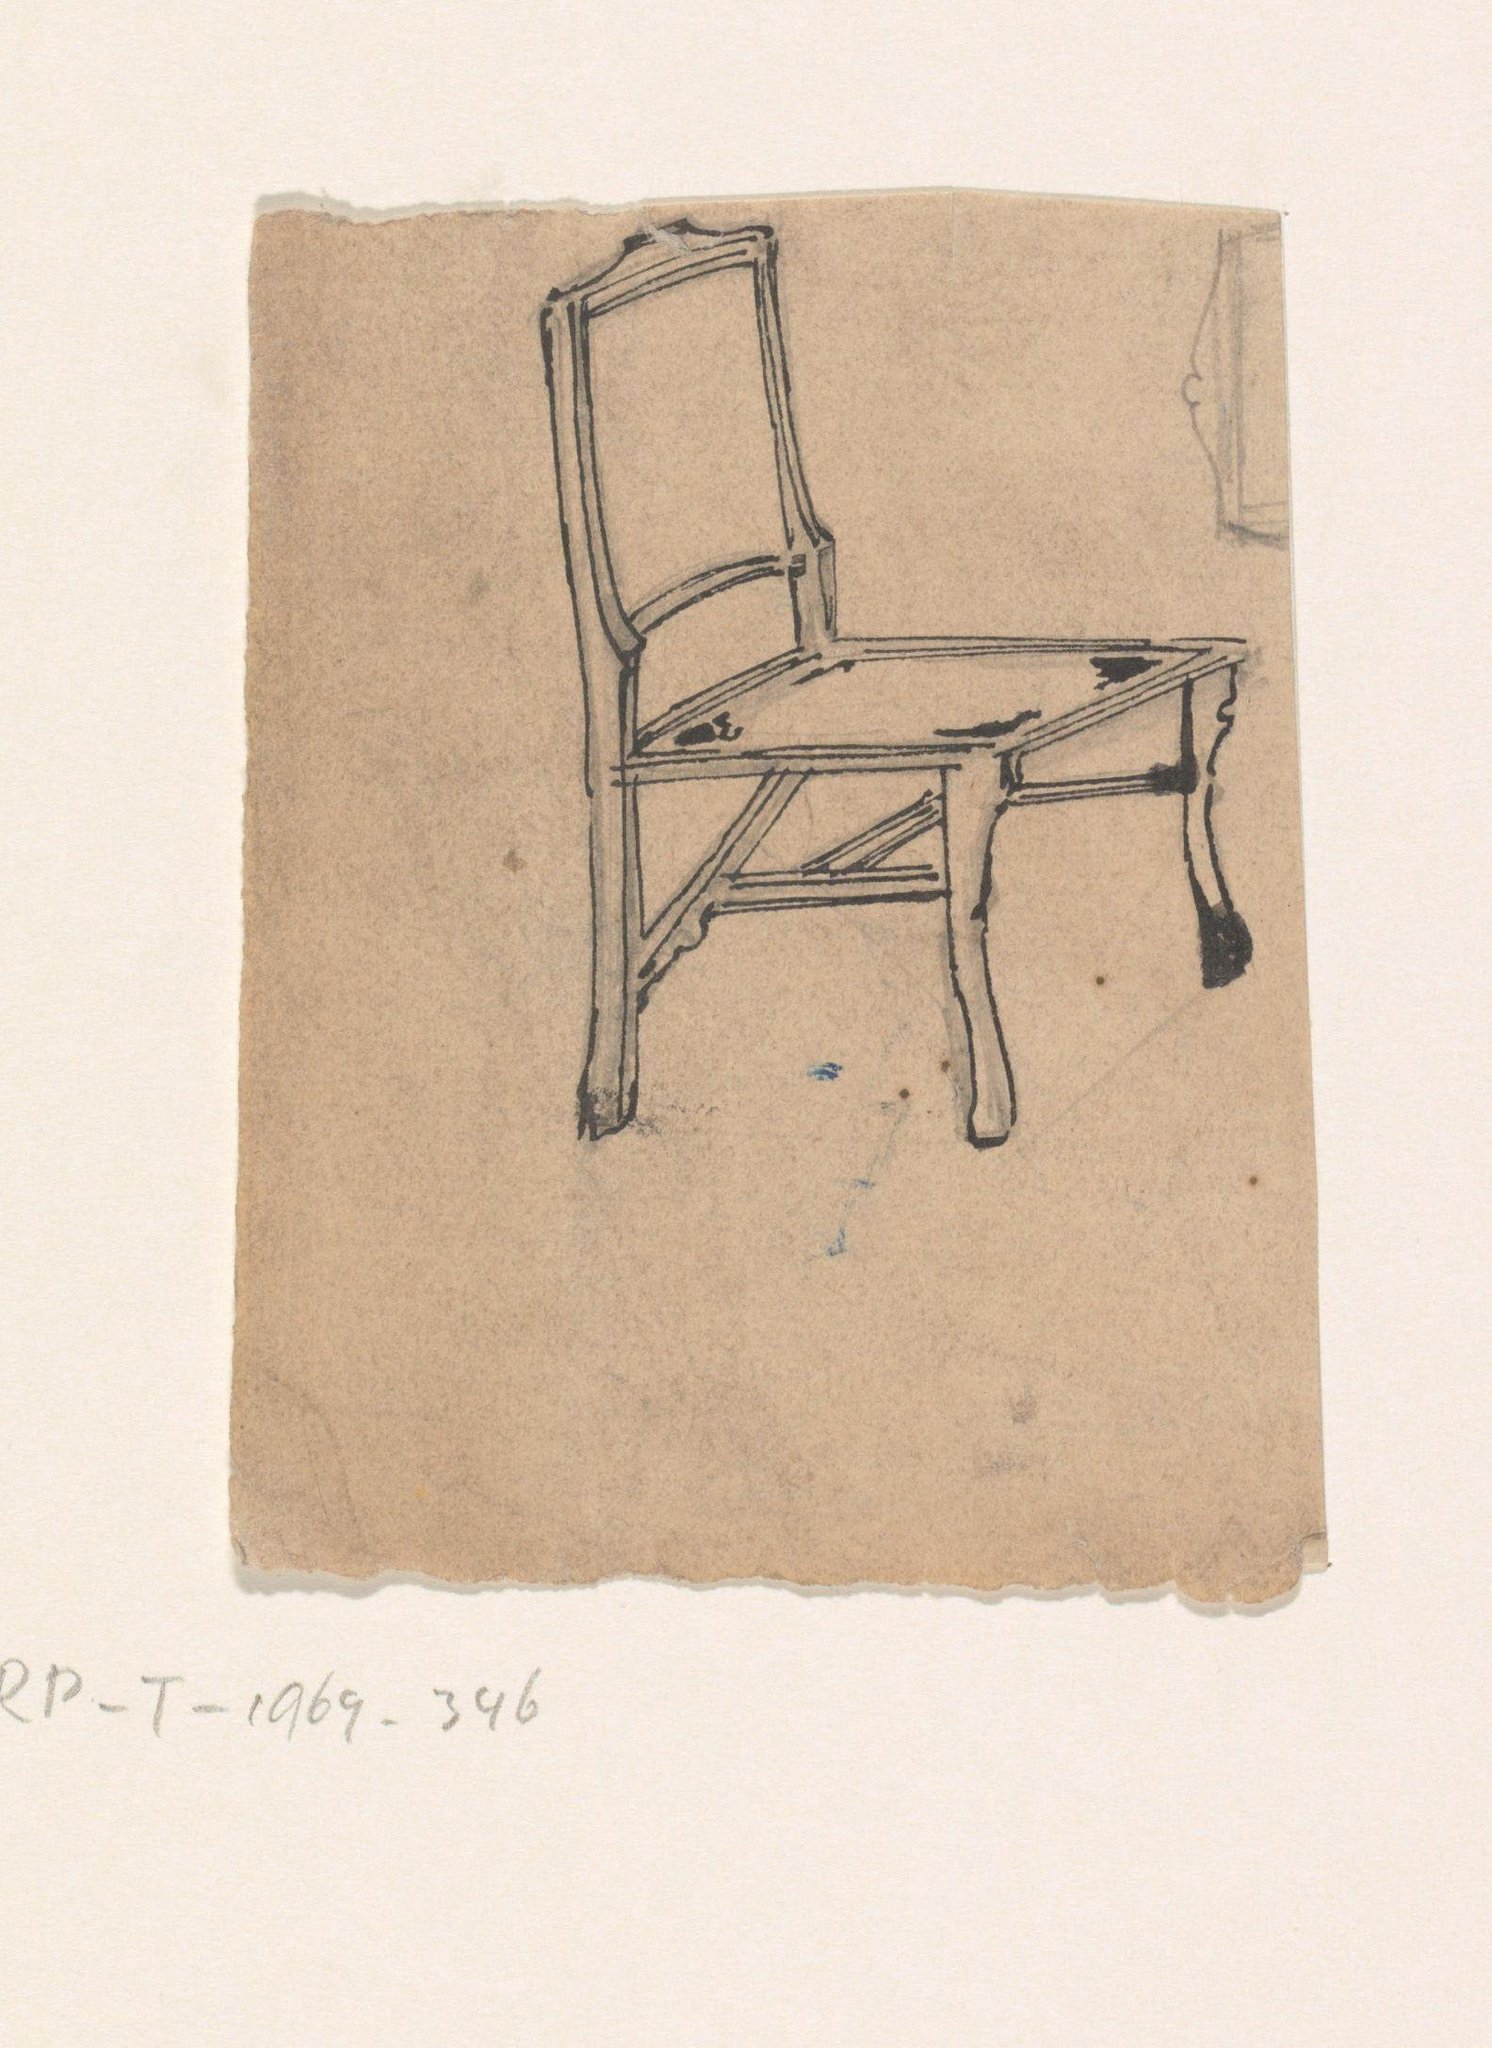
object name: drawing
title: Ontwerp voor een stoel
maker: carel adolph lion cachet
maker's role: draughtsman, print maker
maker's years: 1864-1945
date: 1874-1945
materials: ink, paper, pencil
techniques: pen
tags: chair